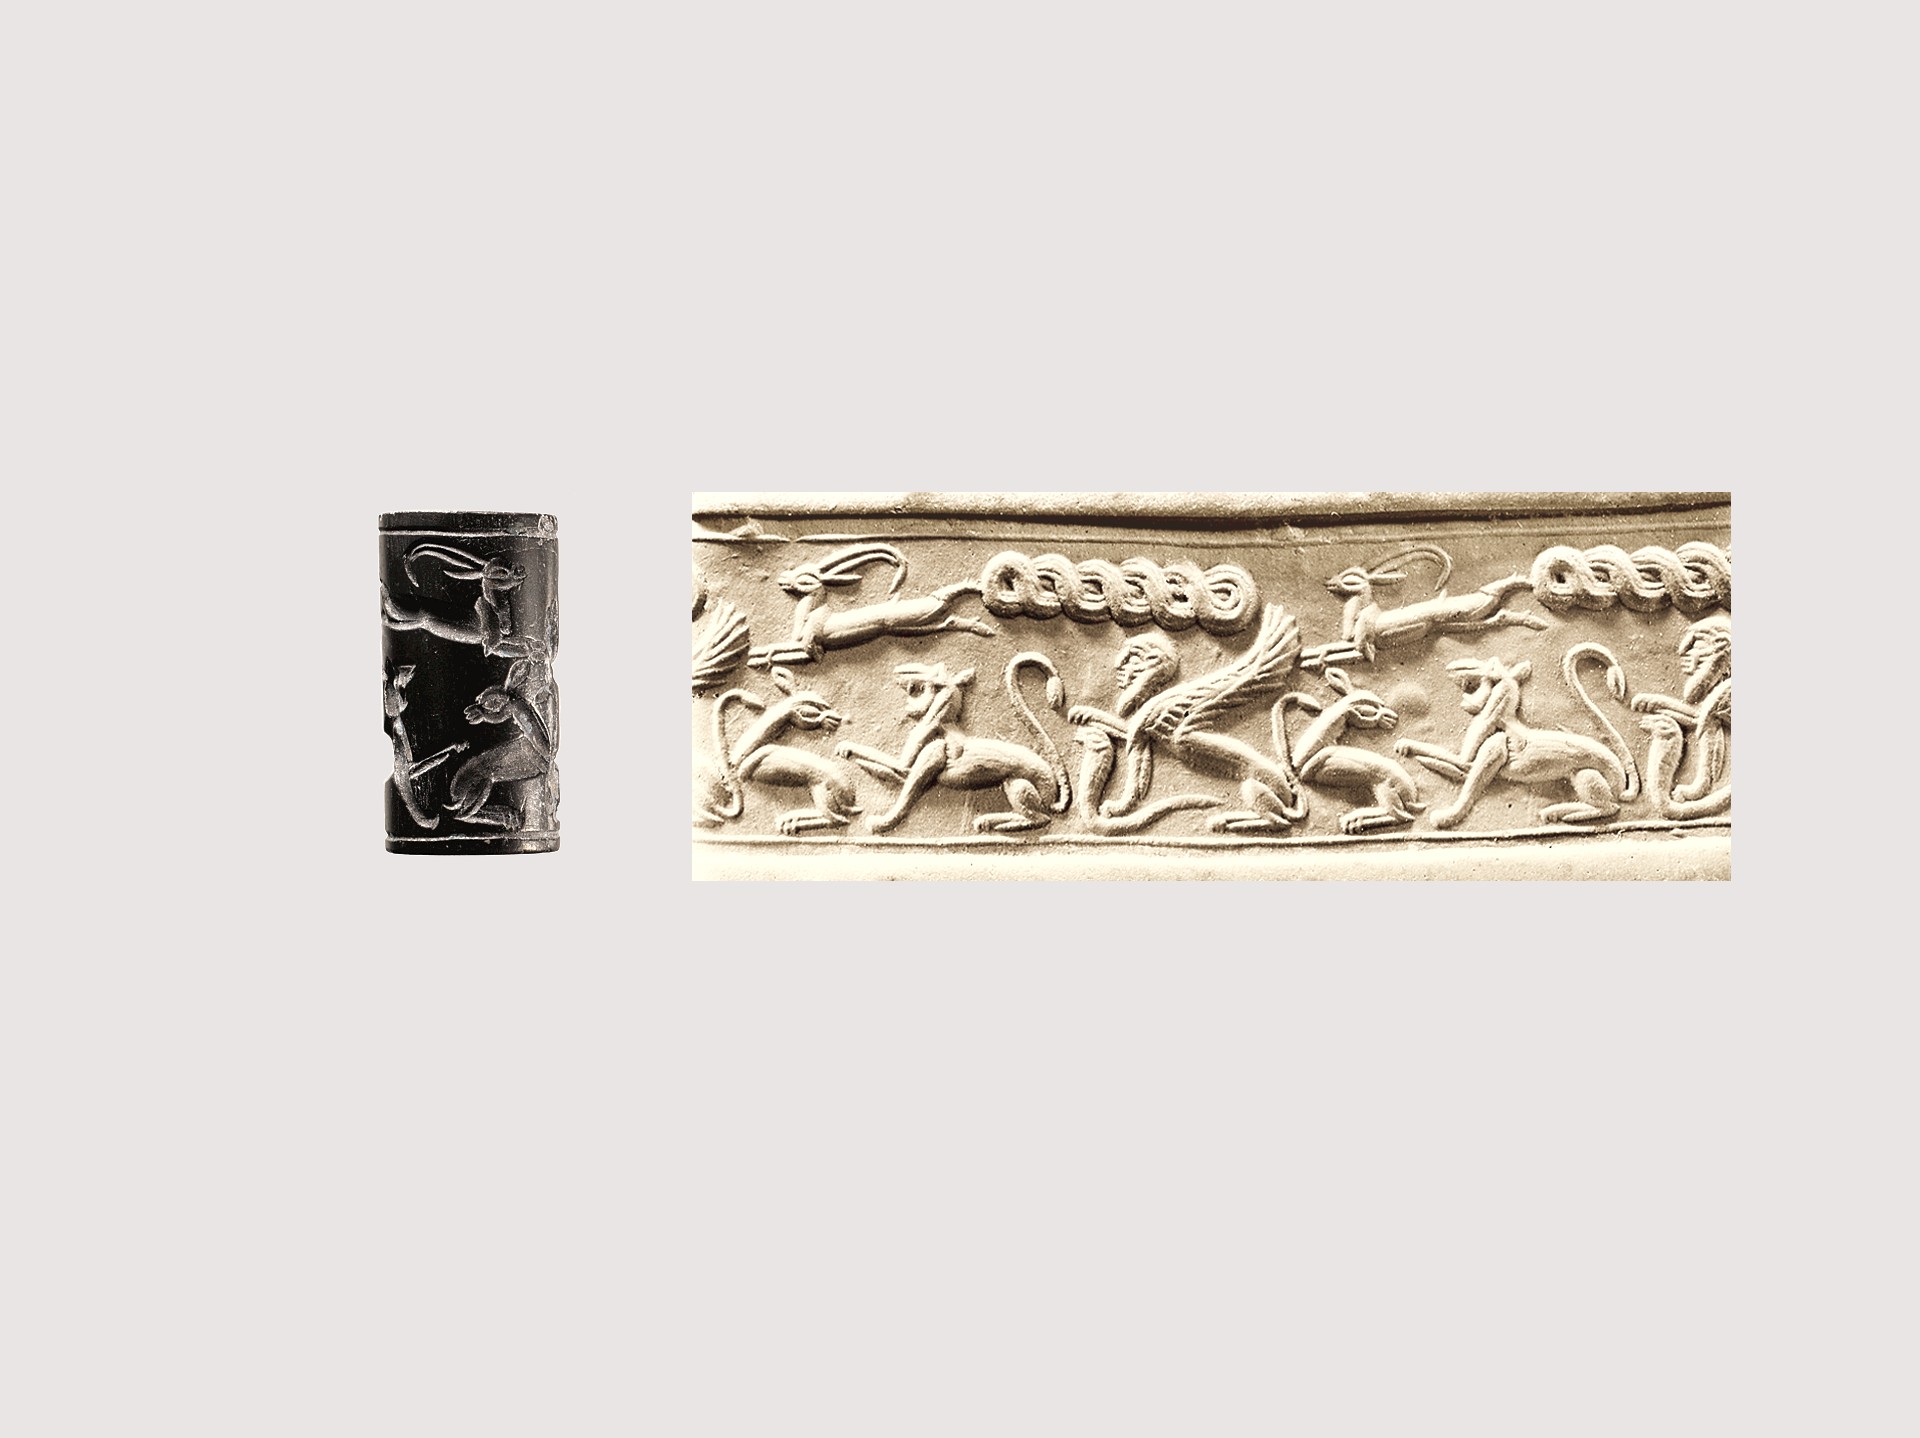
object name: cylinder seal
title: Cylinder seal and modern impression: animal combat and sphinx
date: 2000-1668 BCE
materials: mineral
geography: syria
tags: animals,sphinx